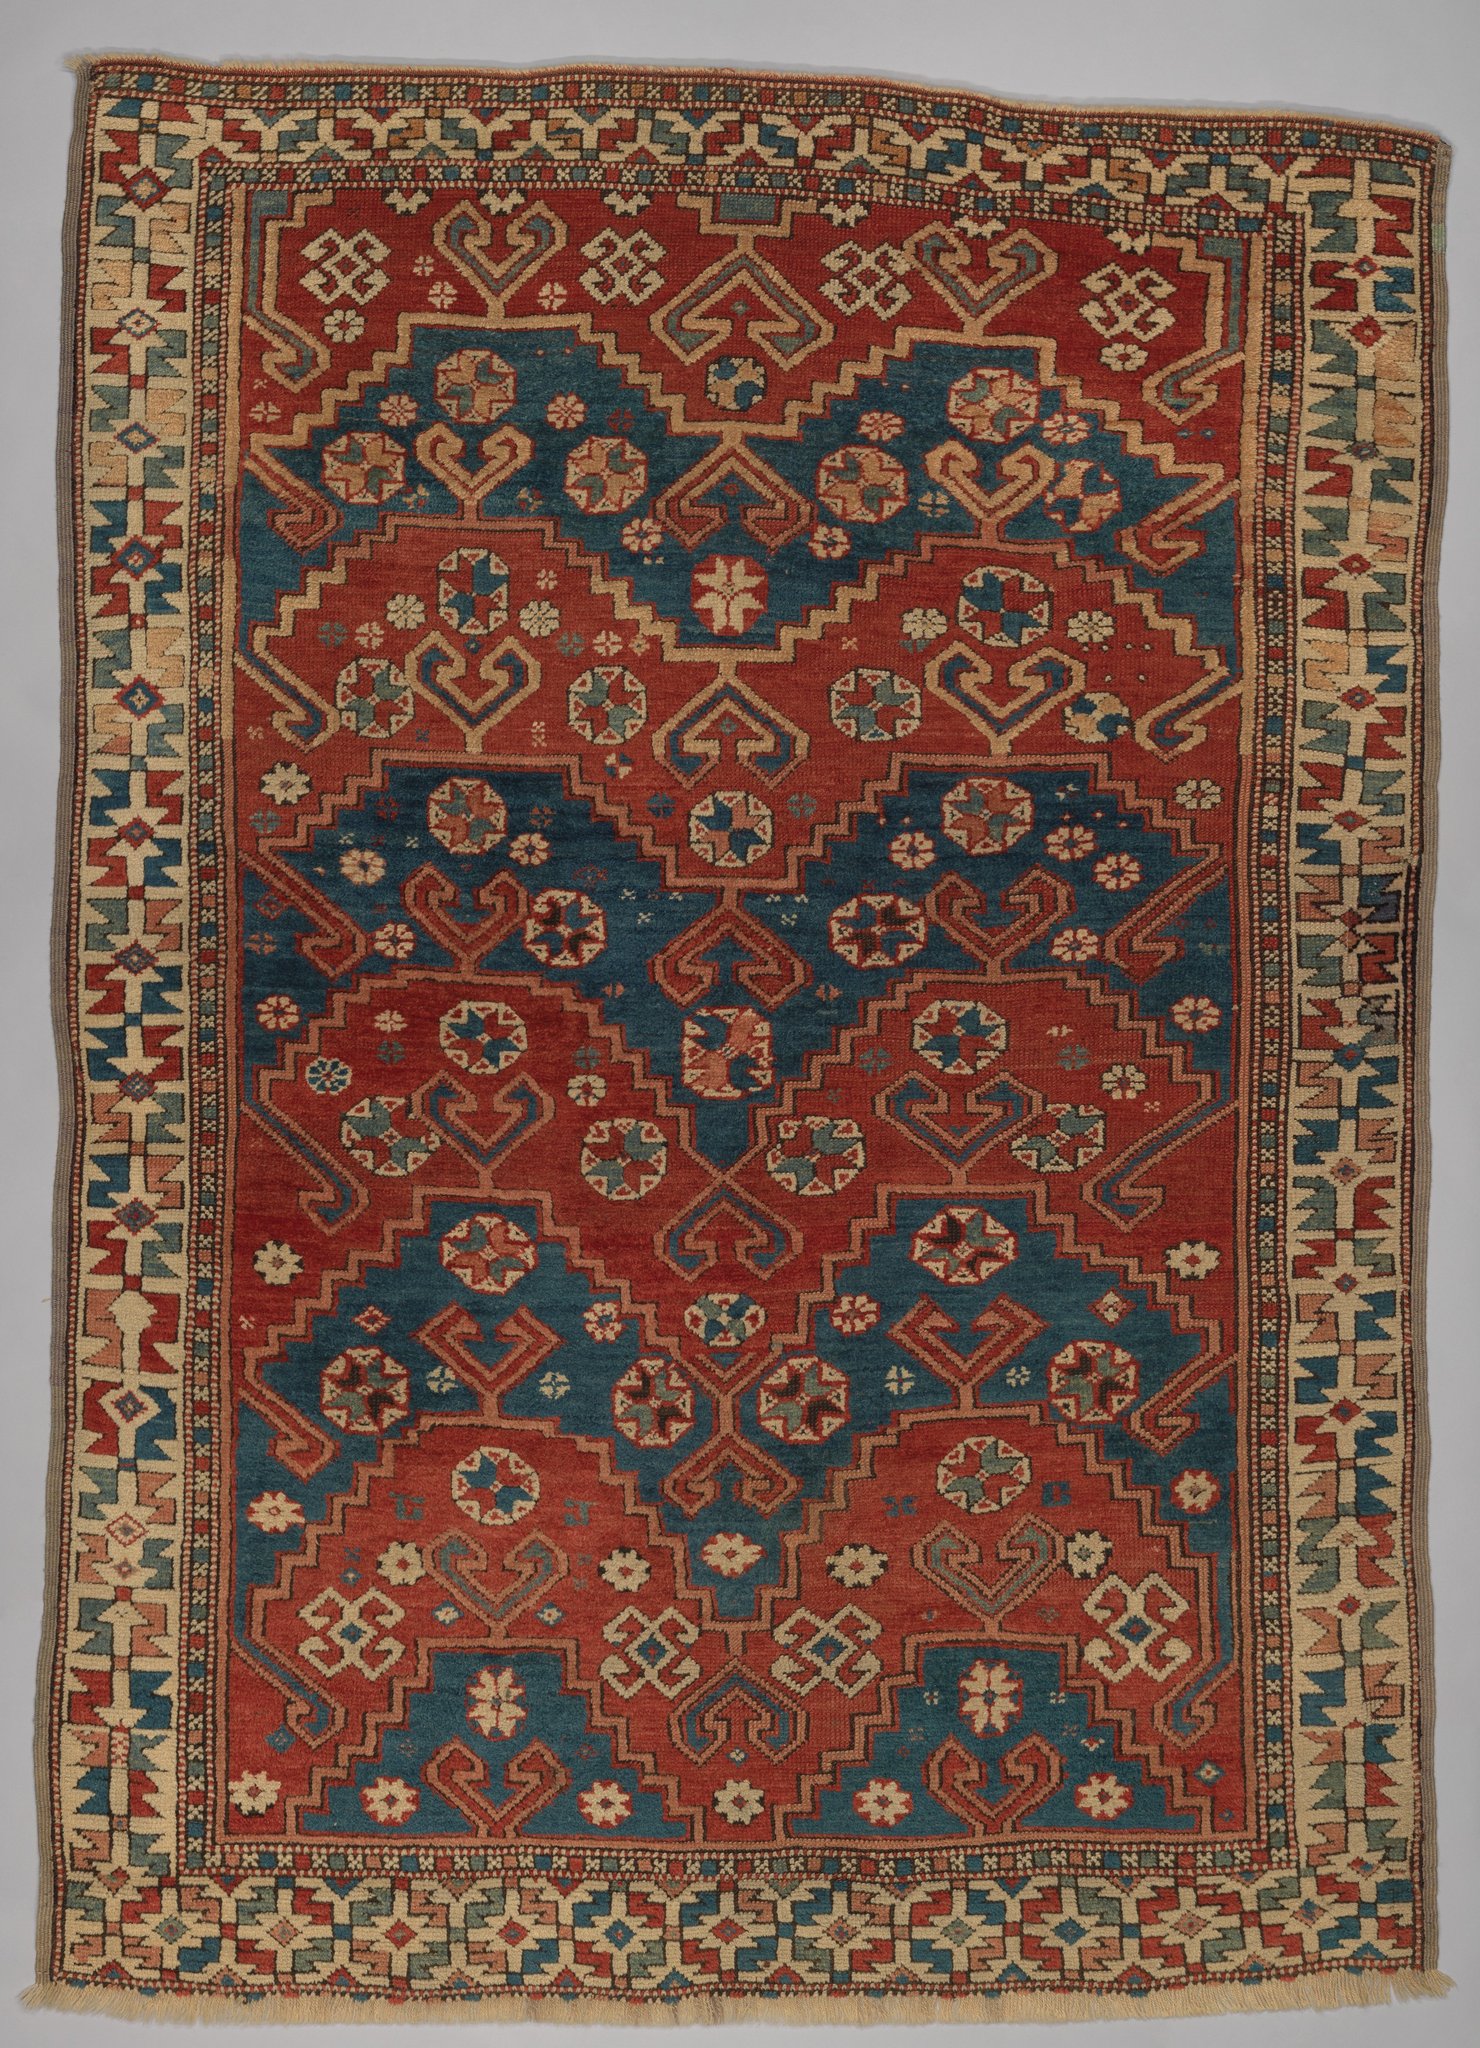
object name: carpet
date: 1801-1850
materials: wool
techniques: pile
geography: turkey